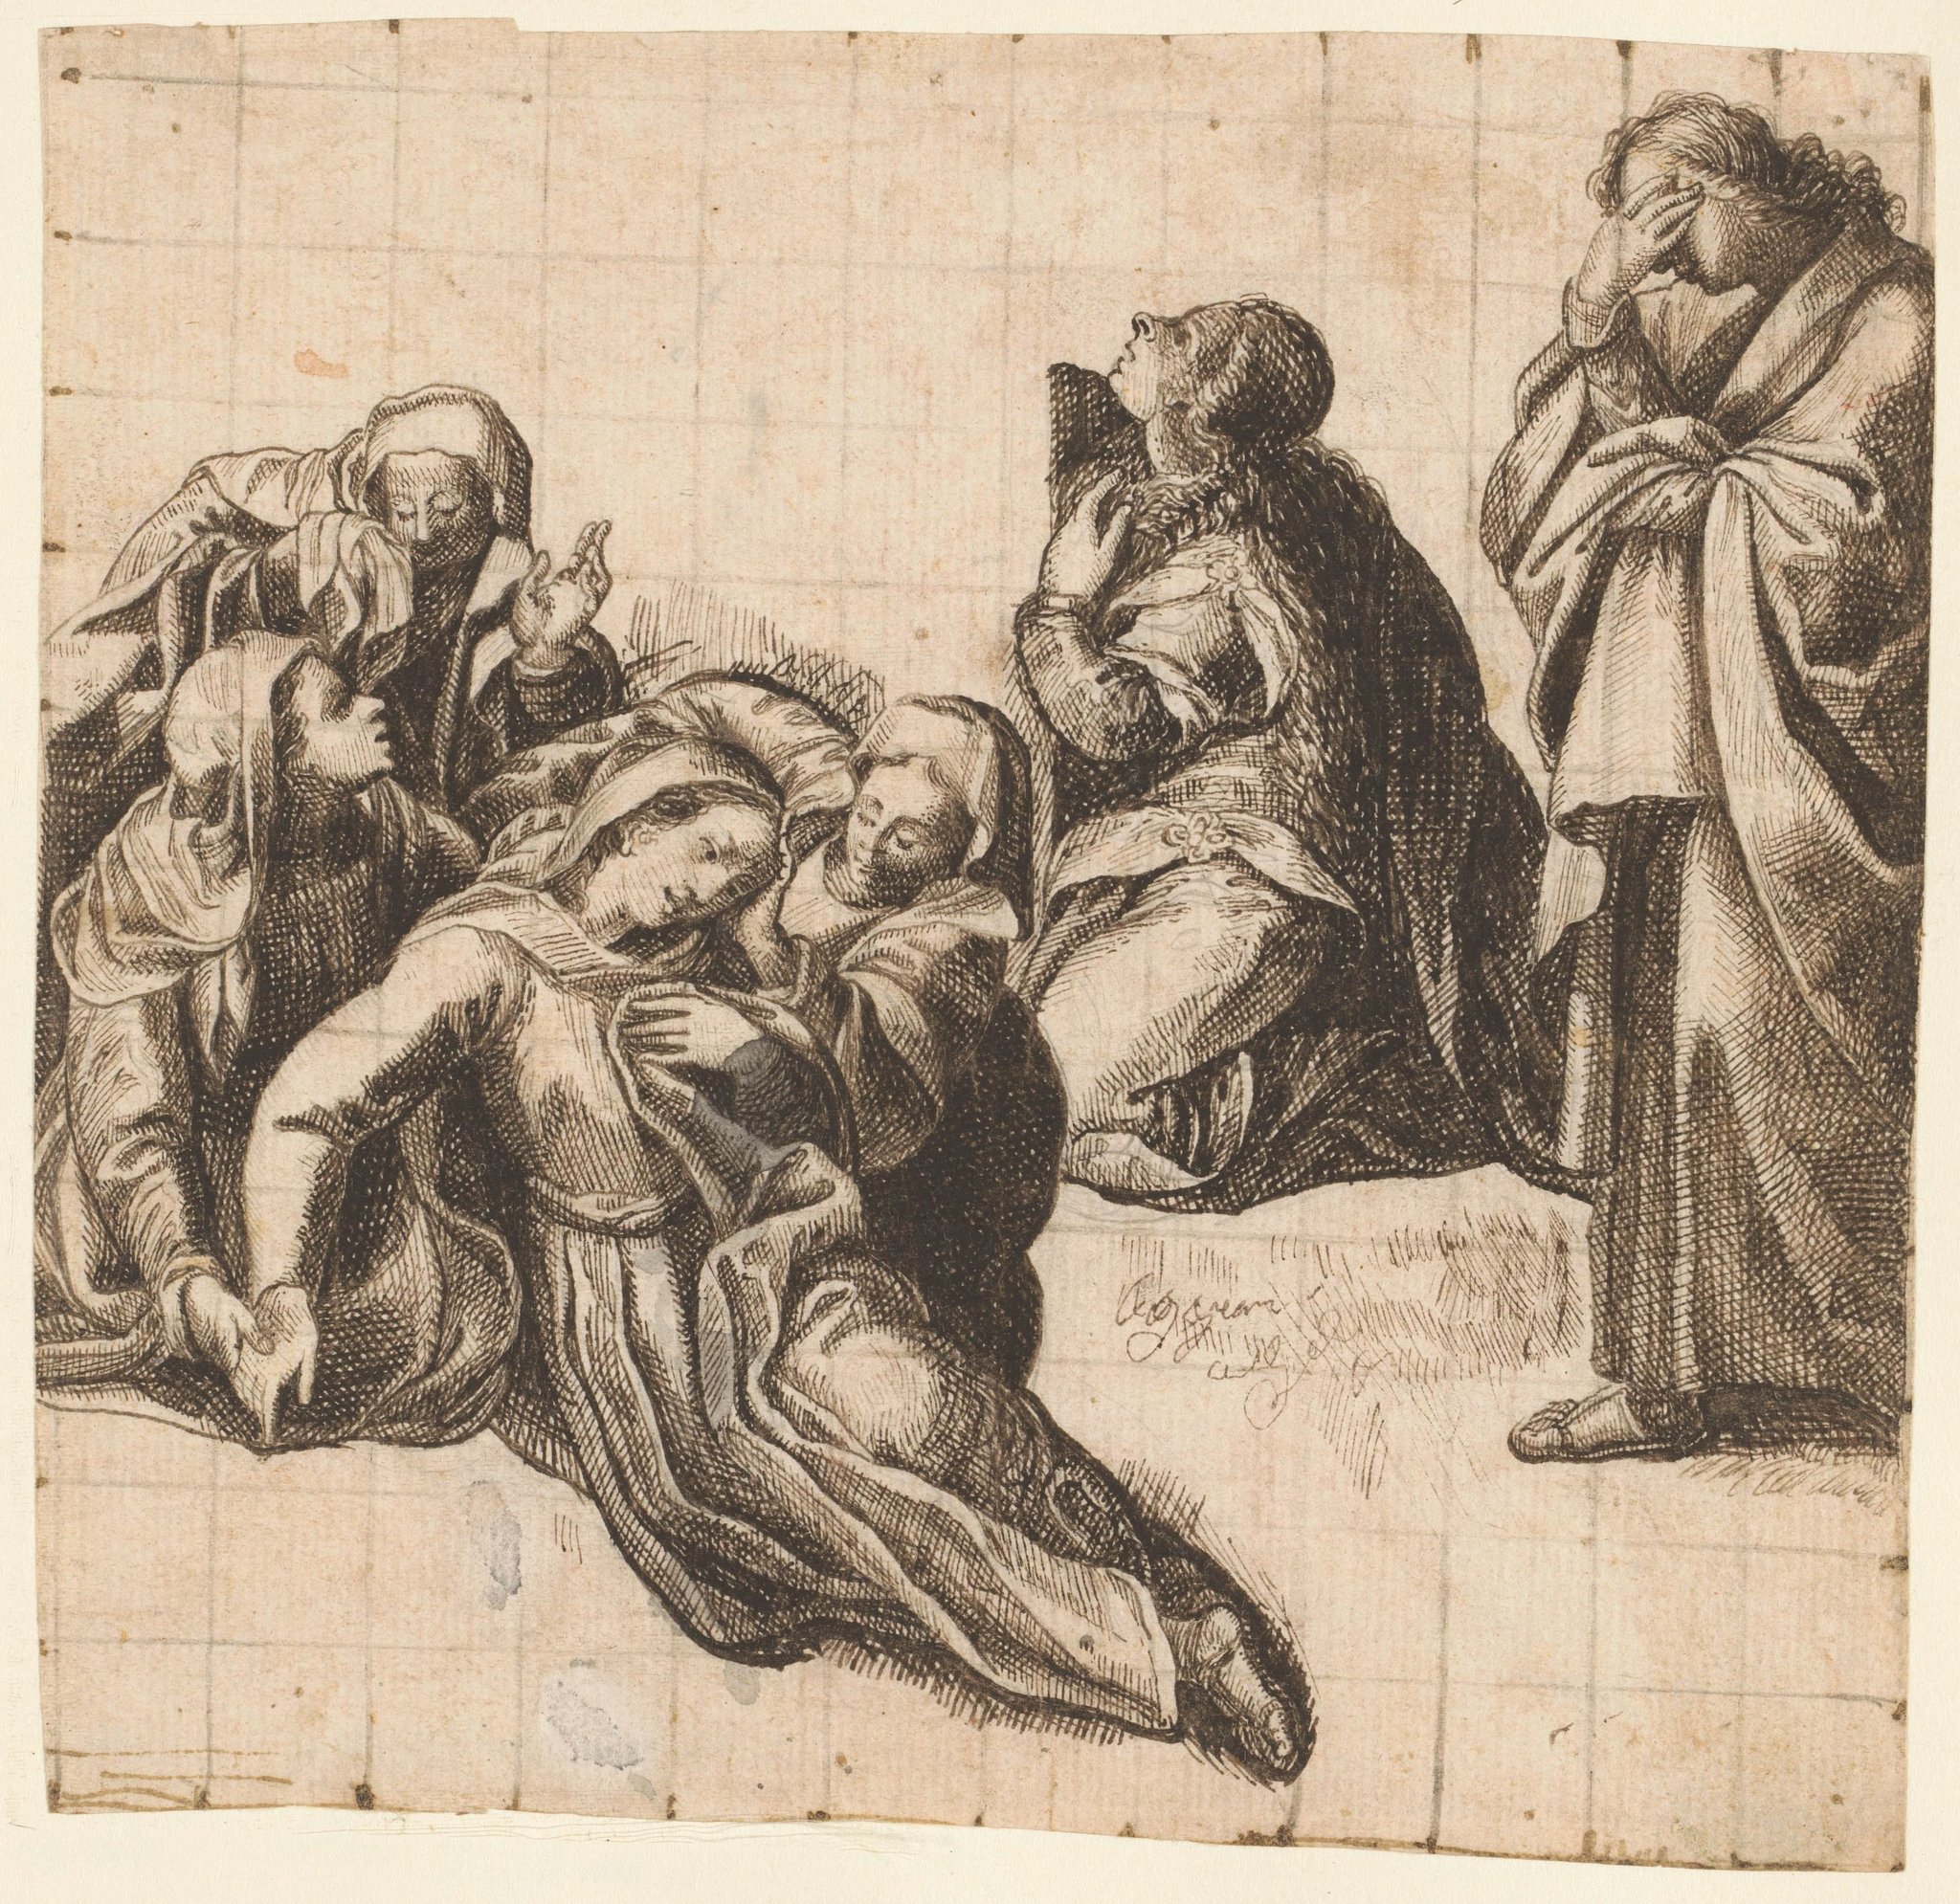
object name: drawing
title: Maria, Johannes en anderen onder het kruis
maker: Anonymous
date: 1500-1599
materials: ink, paper, pencil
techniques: brush, pen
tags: crucified christ with mary, john, and mary magdalene